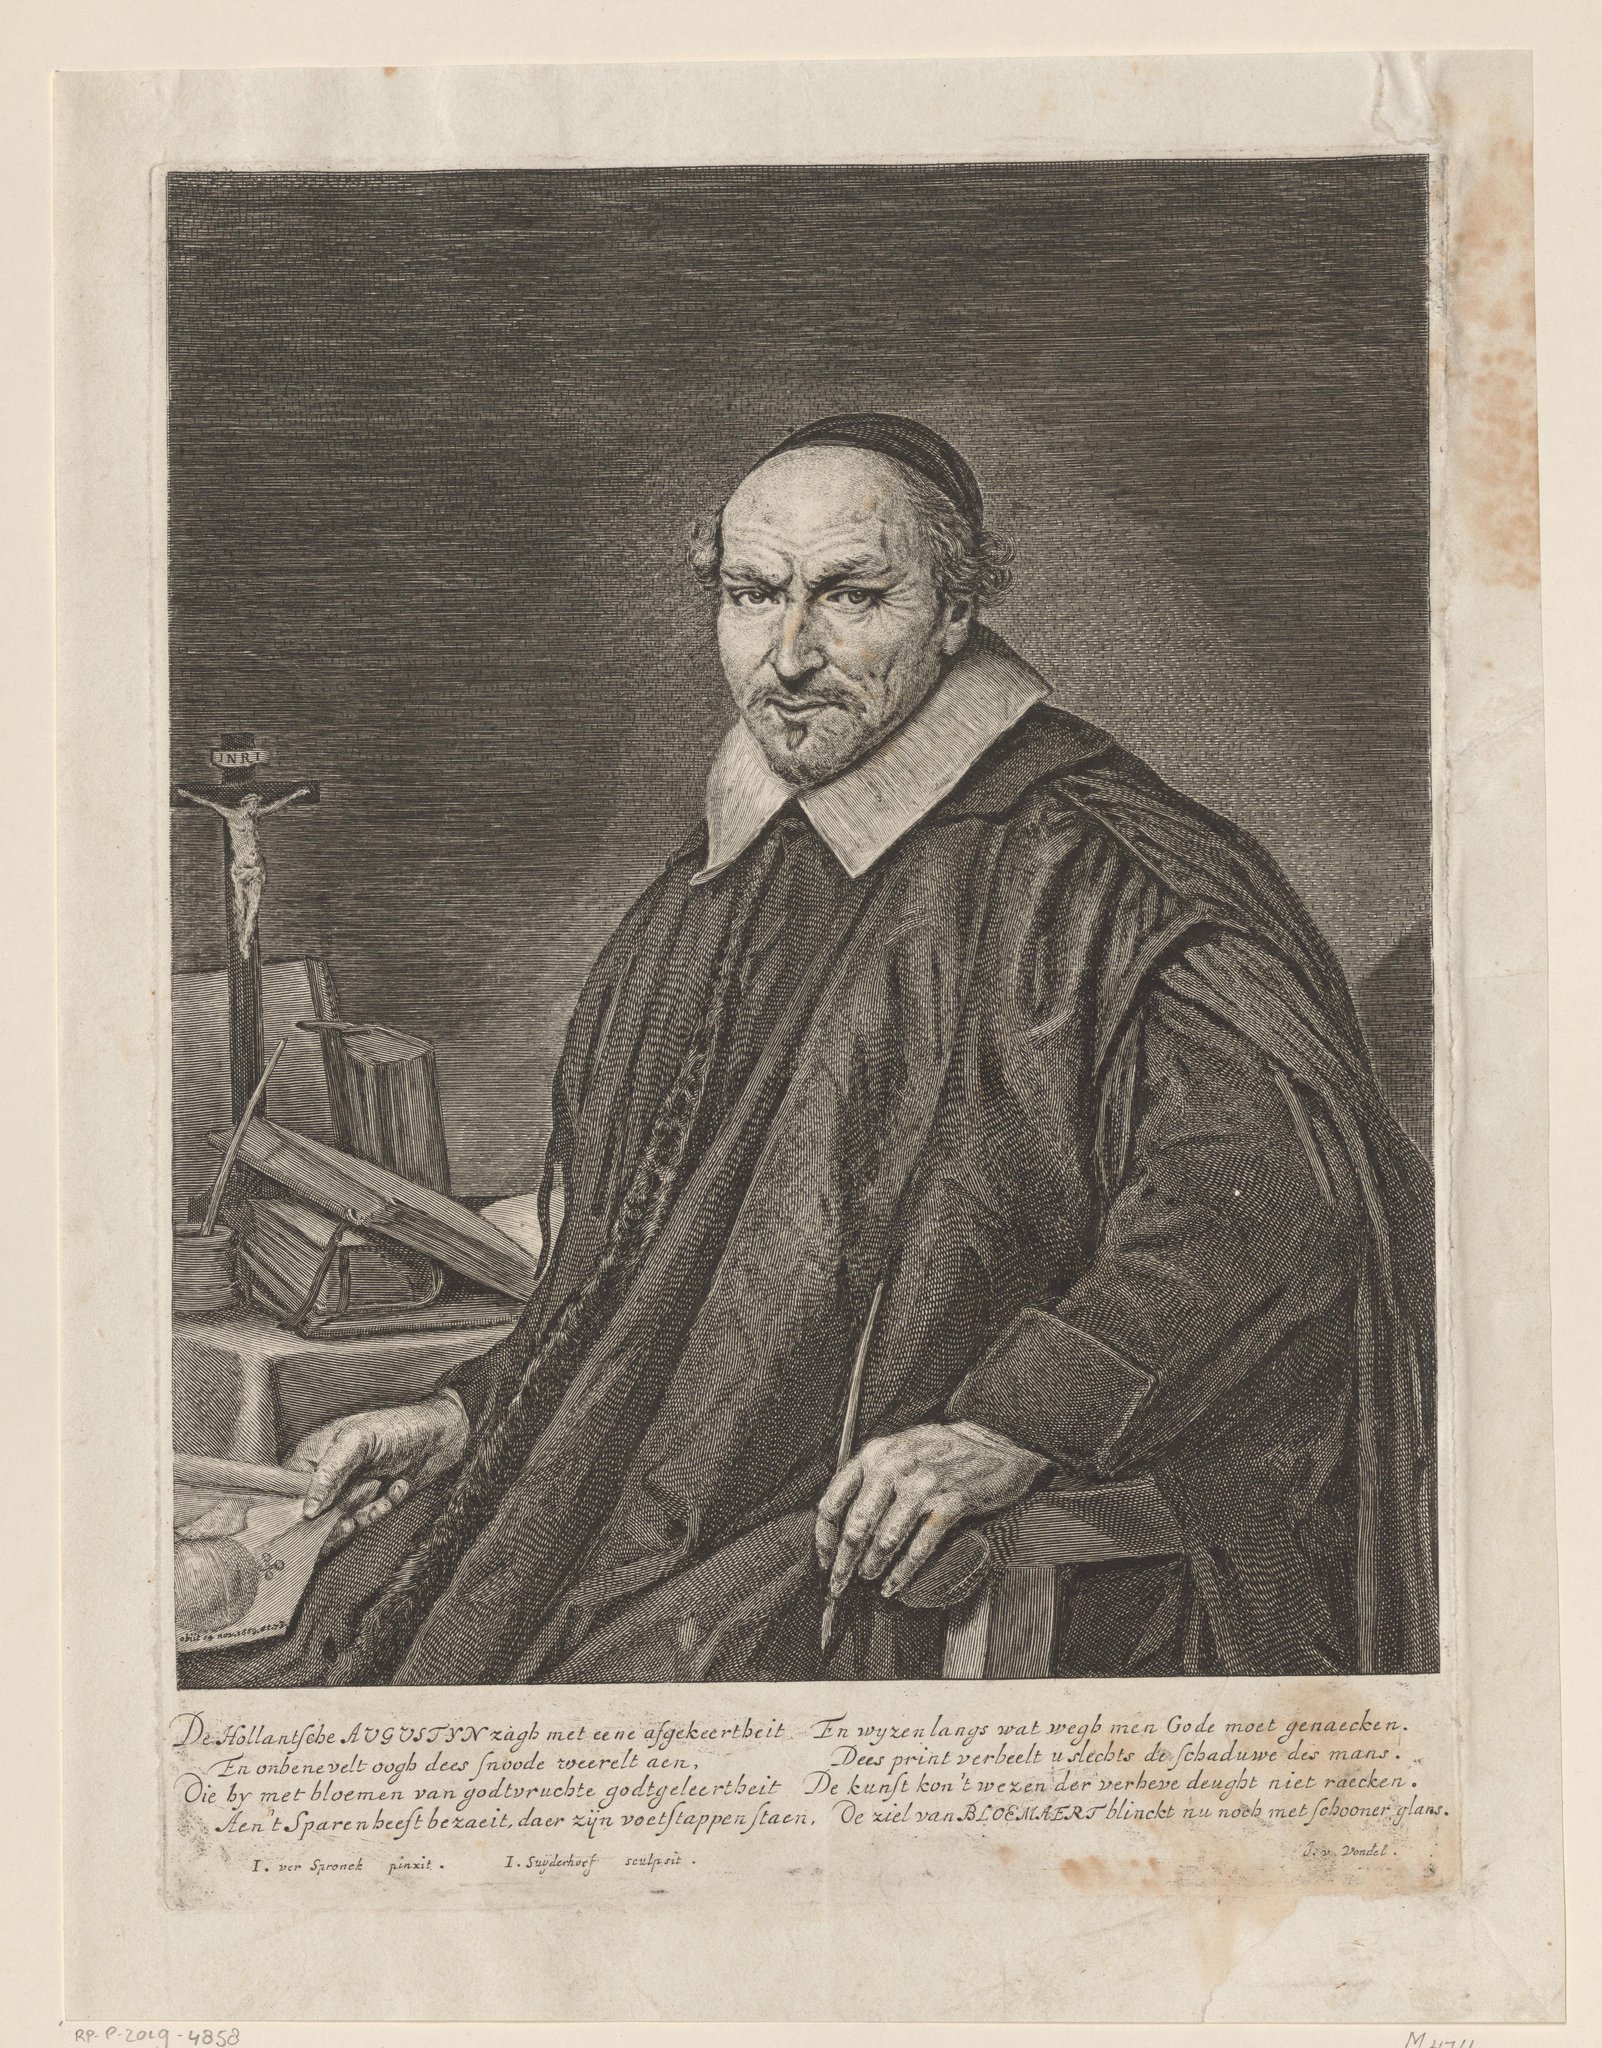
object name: print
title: Portret van Augustyn Alsten Bloemaert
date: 1659-1686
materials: paper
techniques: engraving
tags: haarlem, historical persons, book, crucifix ~ personal devotion